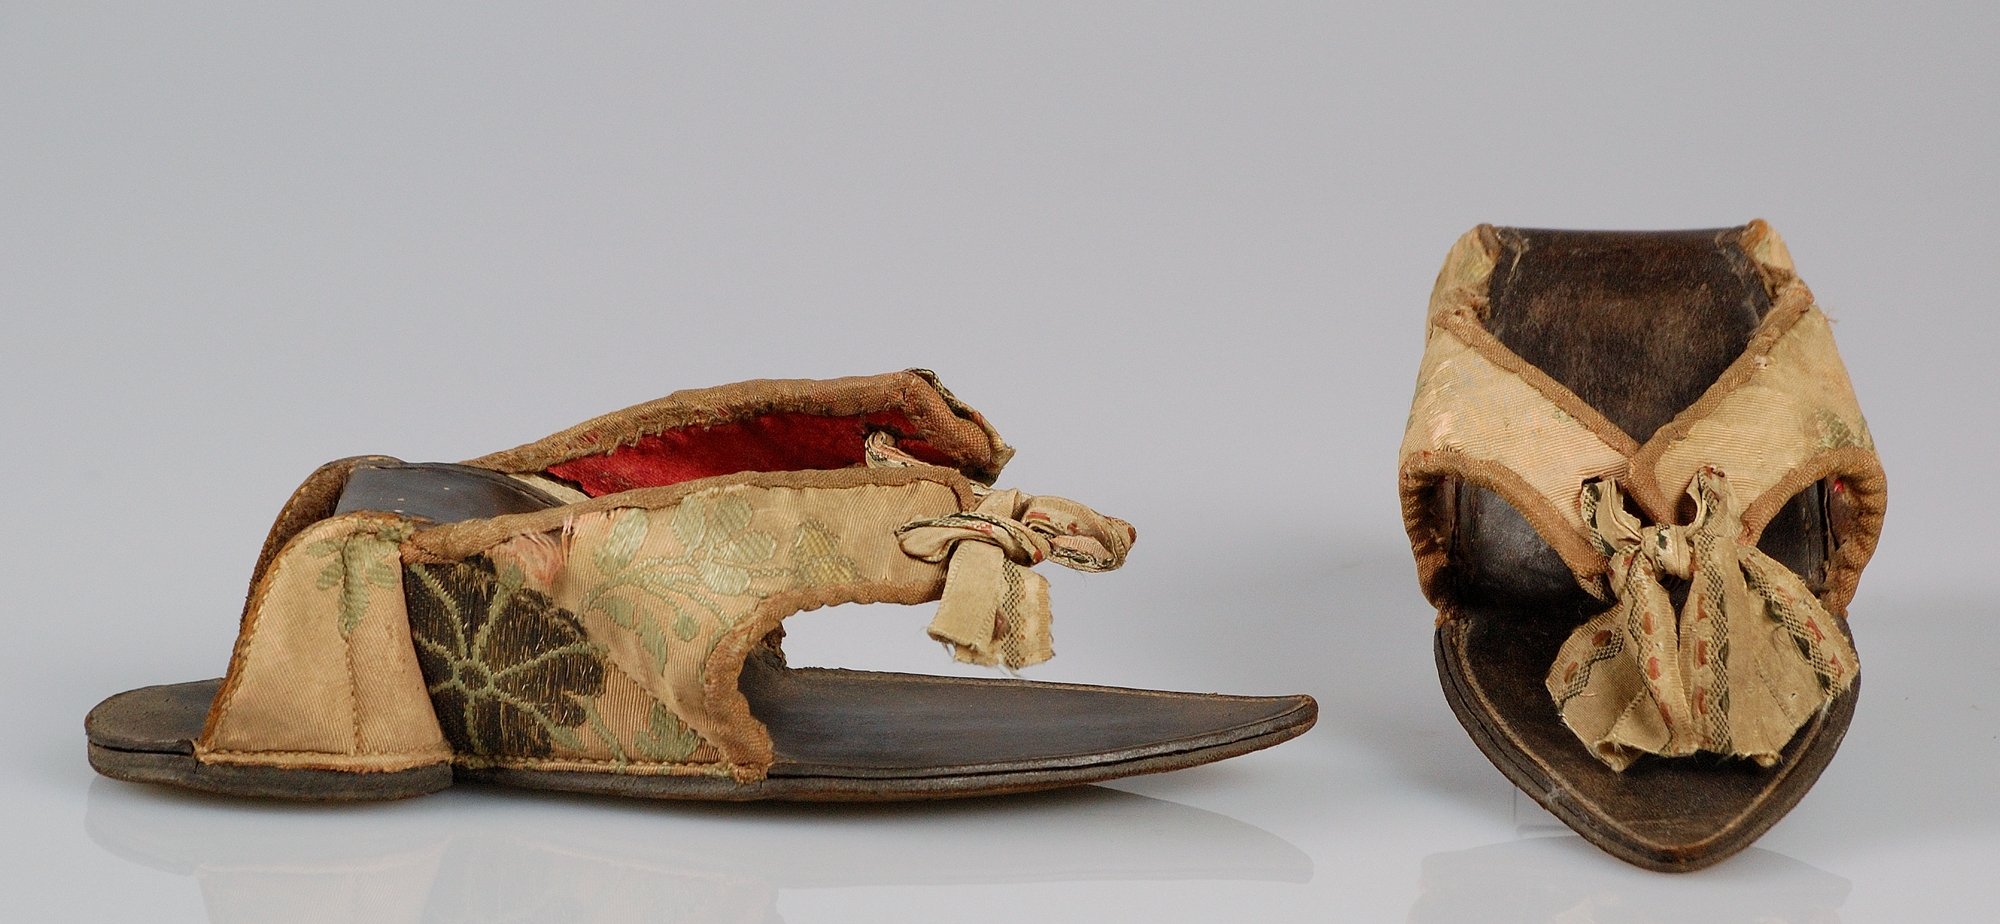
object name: patten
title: Pattens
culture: european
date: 1701-1733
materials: silk